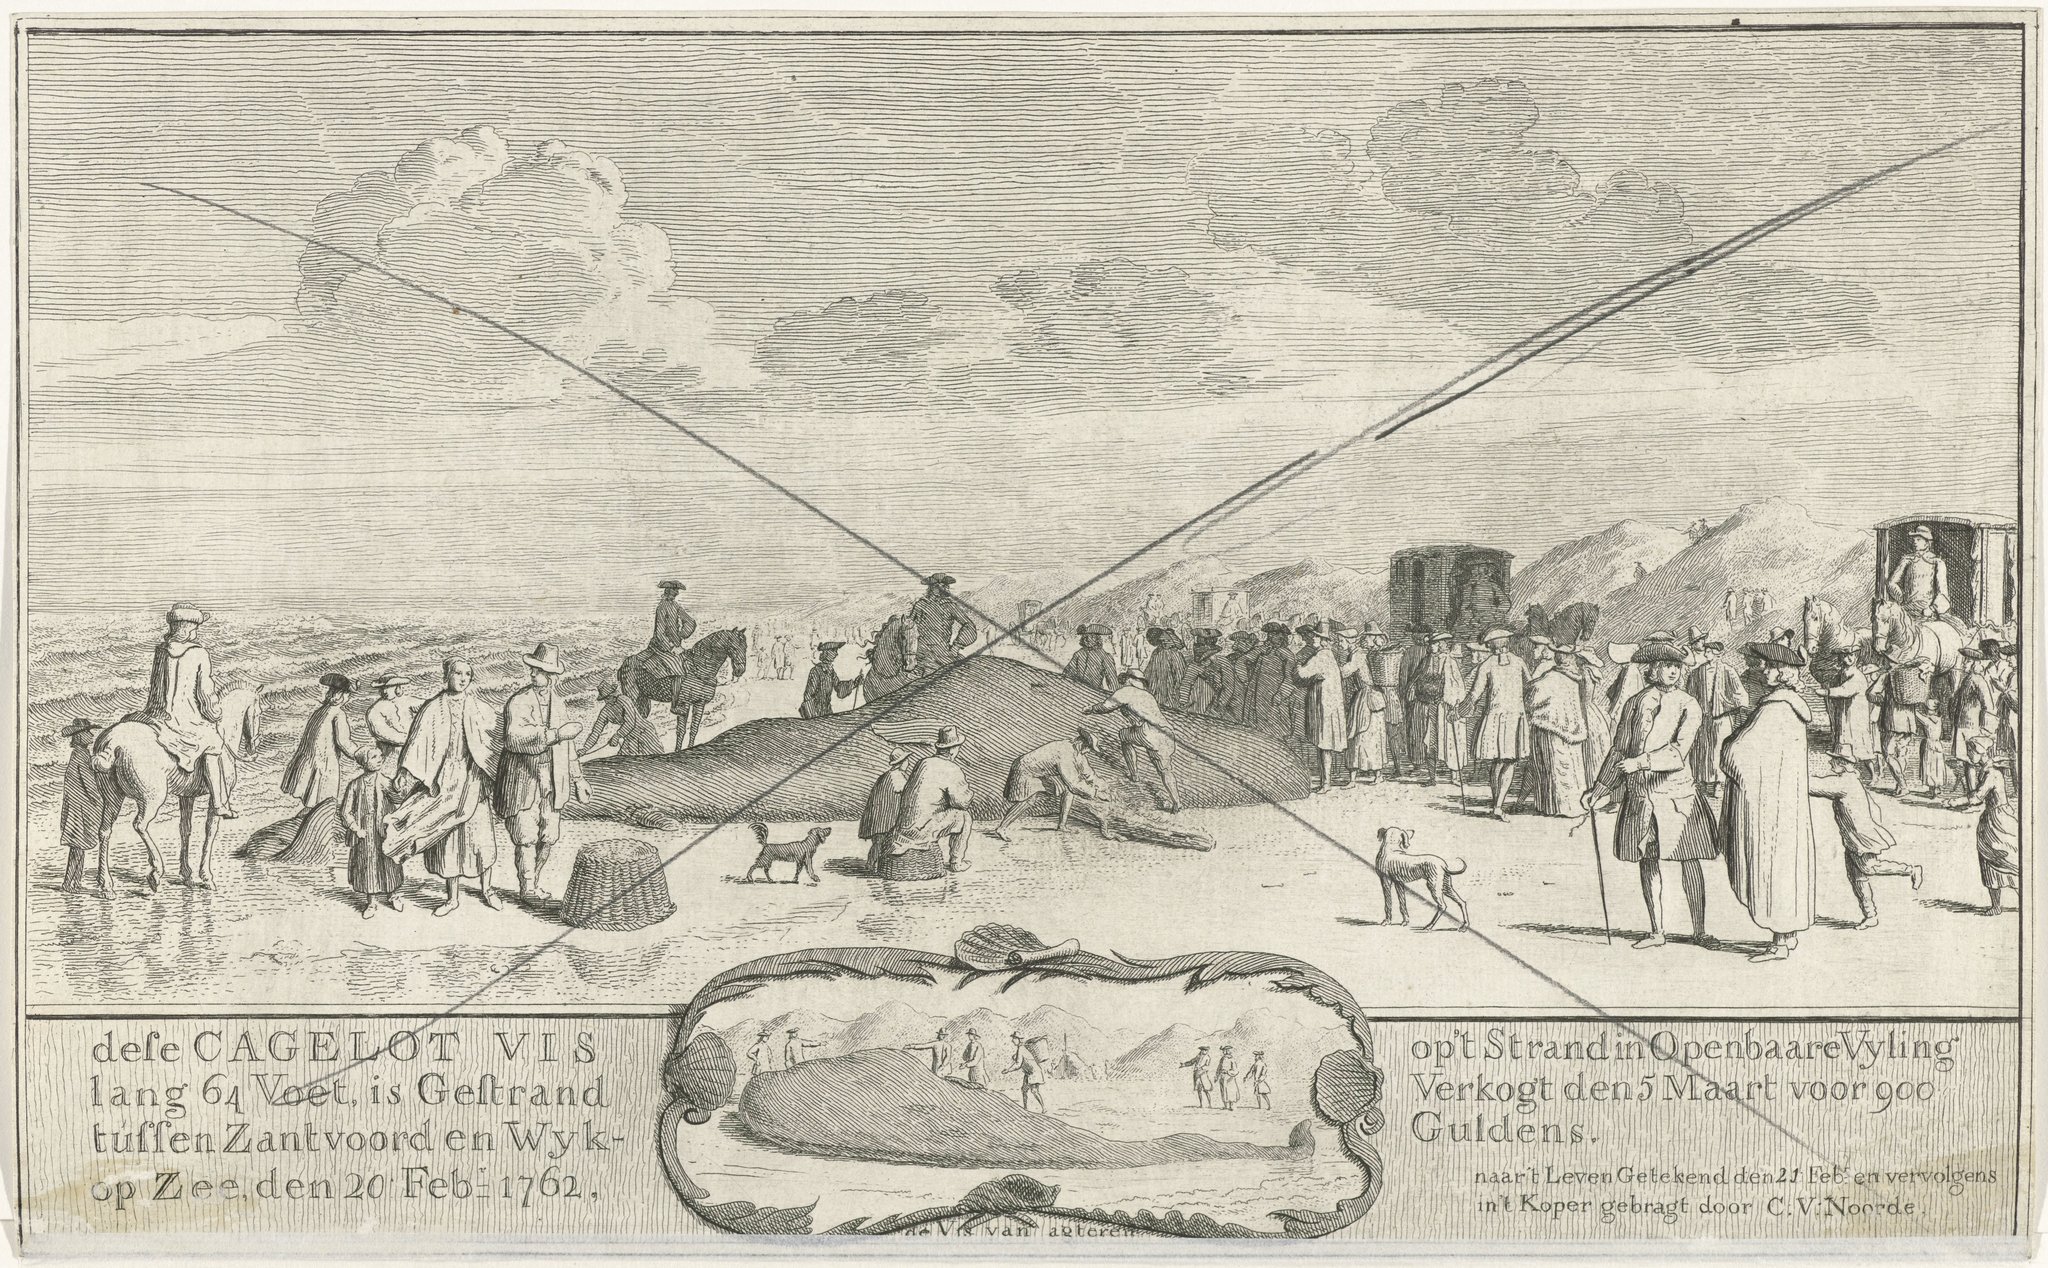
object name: print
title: Aangespoelde potvis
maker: cornelis van noorde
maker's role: draughtsman, print maker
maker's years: 1731-1795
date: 1762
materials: paper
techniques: etching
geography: haarlem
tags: swimming mammals: whale (+ dying animal; death of animal; dead animal), beach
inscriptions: date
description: Een aangespoelde potvis op het strand tussen Zandvoort en Wijk aan Zee op 20 februari 1762. De potvis wordt bekeken door een toegestroomde menigte, waarvan sommigen met paard en wagen zijn gekomen. De potvis werd op 5 maart 1762 verkocht voor 900 Gulden. Midden onder een cartouche met de andere zijde van de aangespoelde potvis en een toelichtende tekst in het Nederlands.